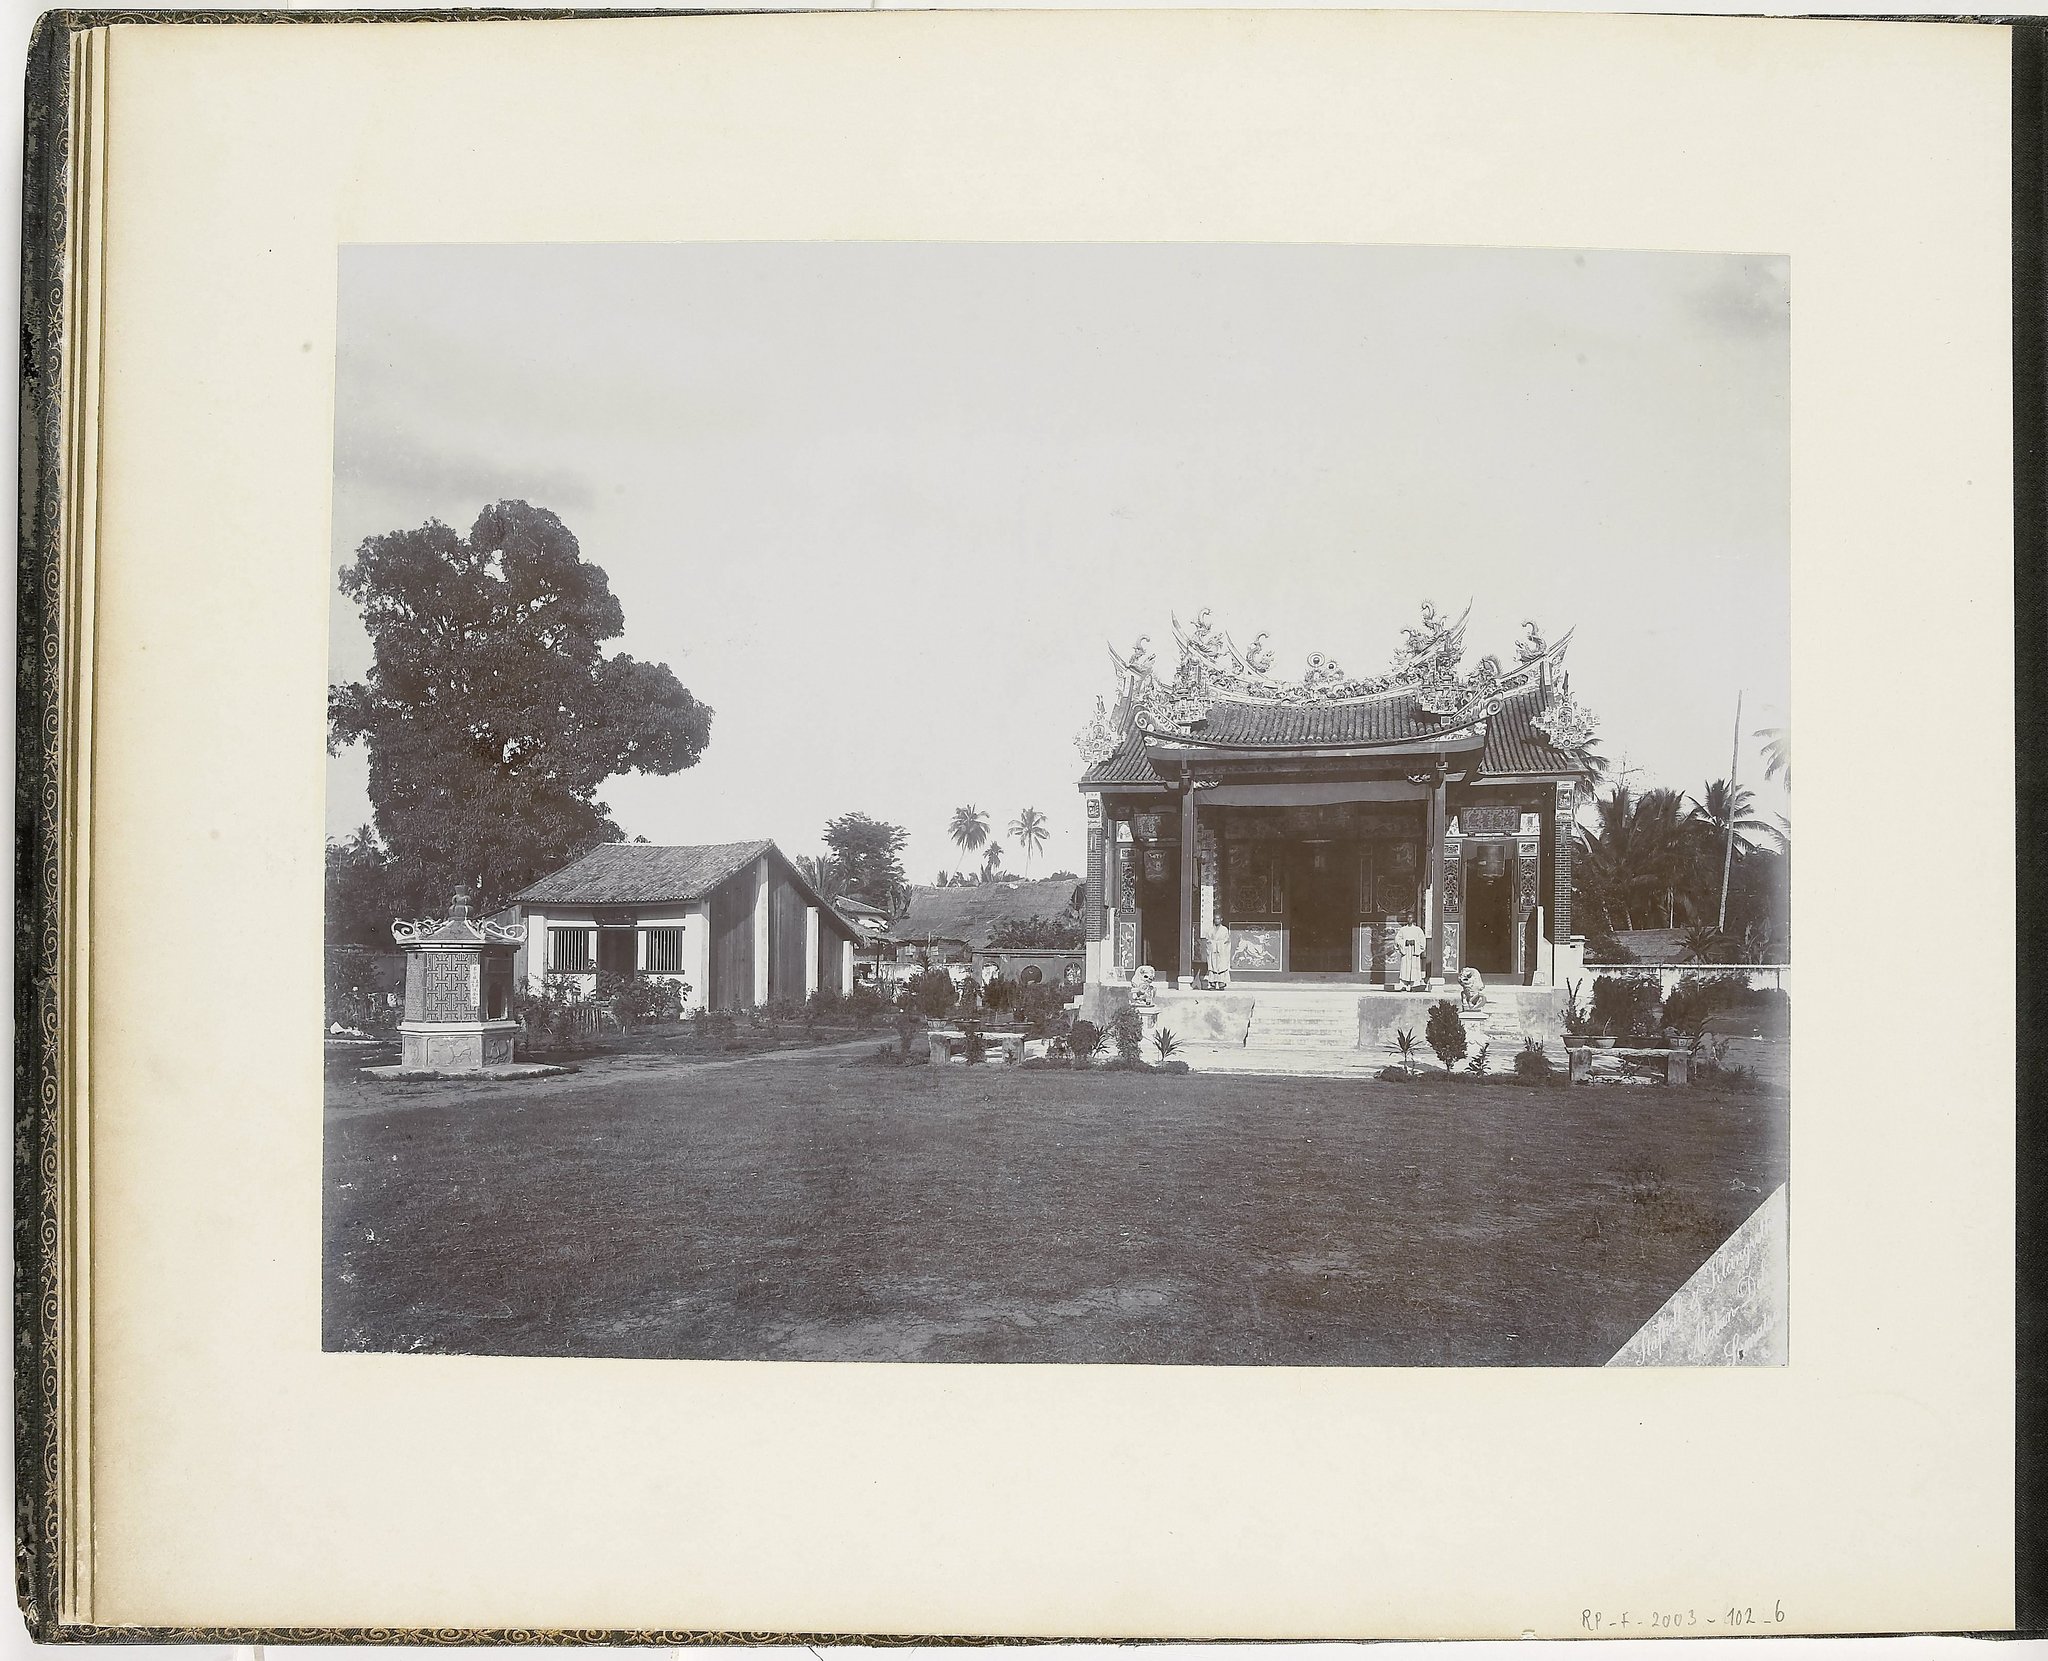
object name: photograph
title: Gezicht op een Chinees tempeltje, Sumatra (Chinesischer Tempel)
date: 1890-1900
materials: photographic support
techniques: collodion silver print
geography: medan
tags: sumatra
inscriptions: signature: ‘Stafhell & Kleingrothe Medan-Deli’, number: ‘Sumatra 6’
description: Gezicht op een Chinese tempel, waarschijnlijk te Medan. Voor de ingang twee tempelwachters of priesters. Onderdeel van het Sumatra fotoalbum van Paul en Lucie Sandel uit 1900.